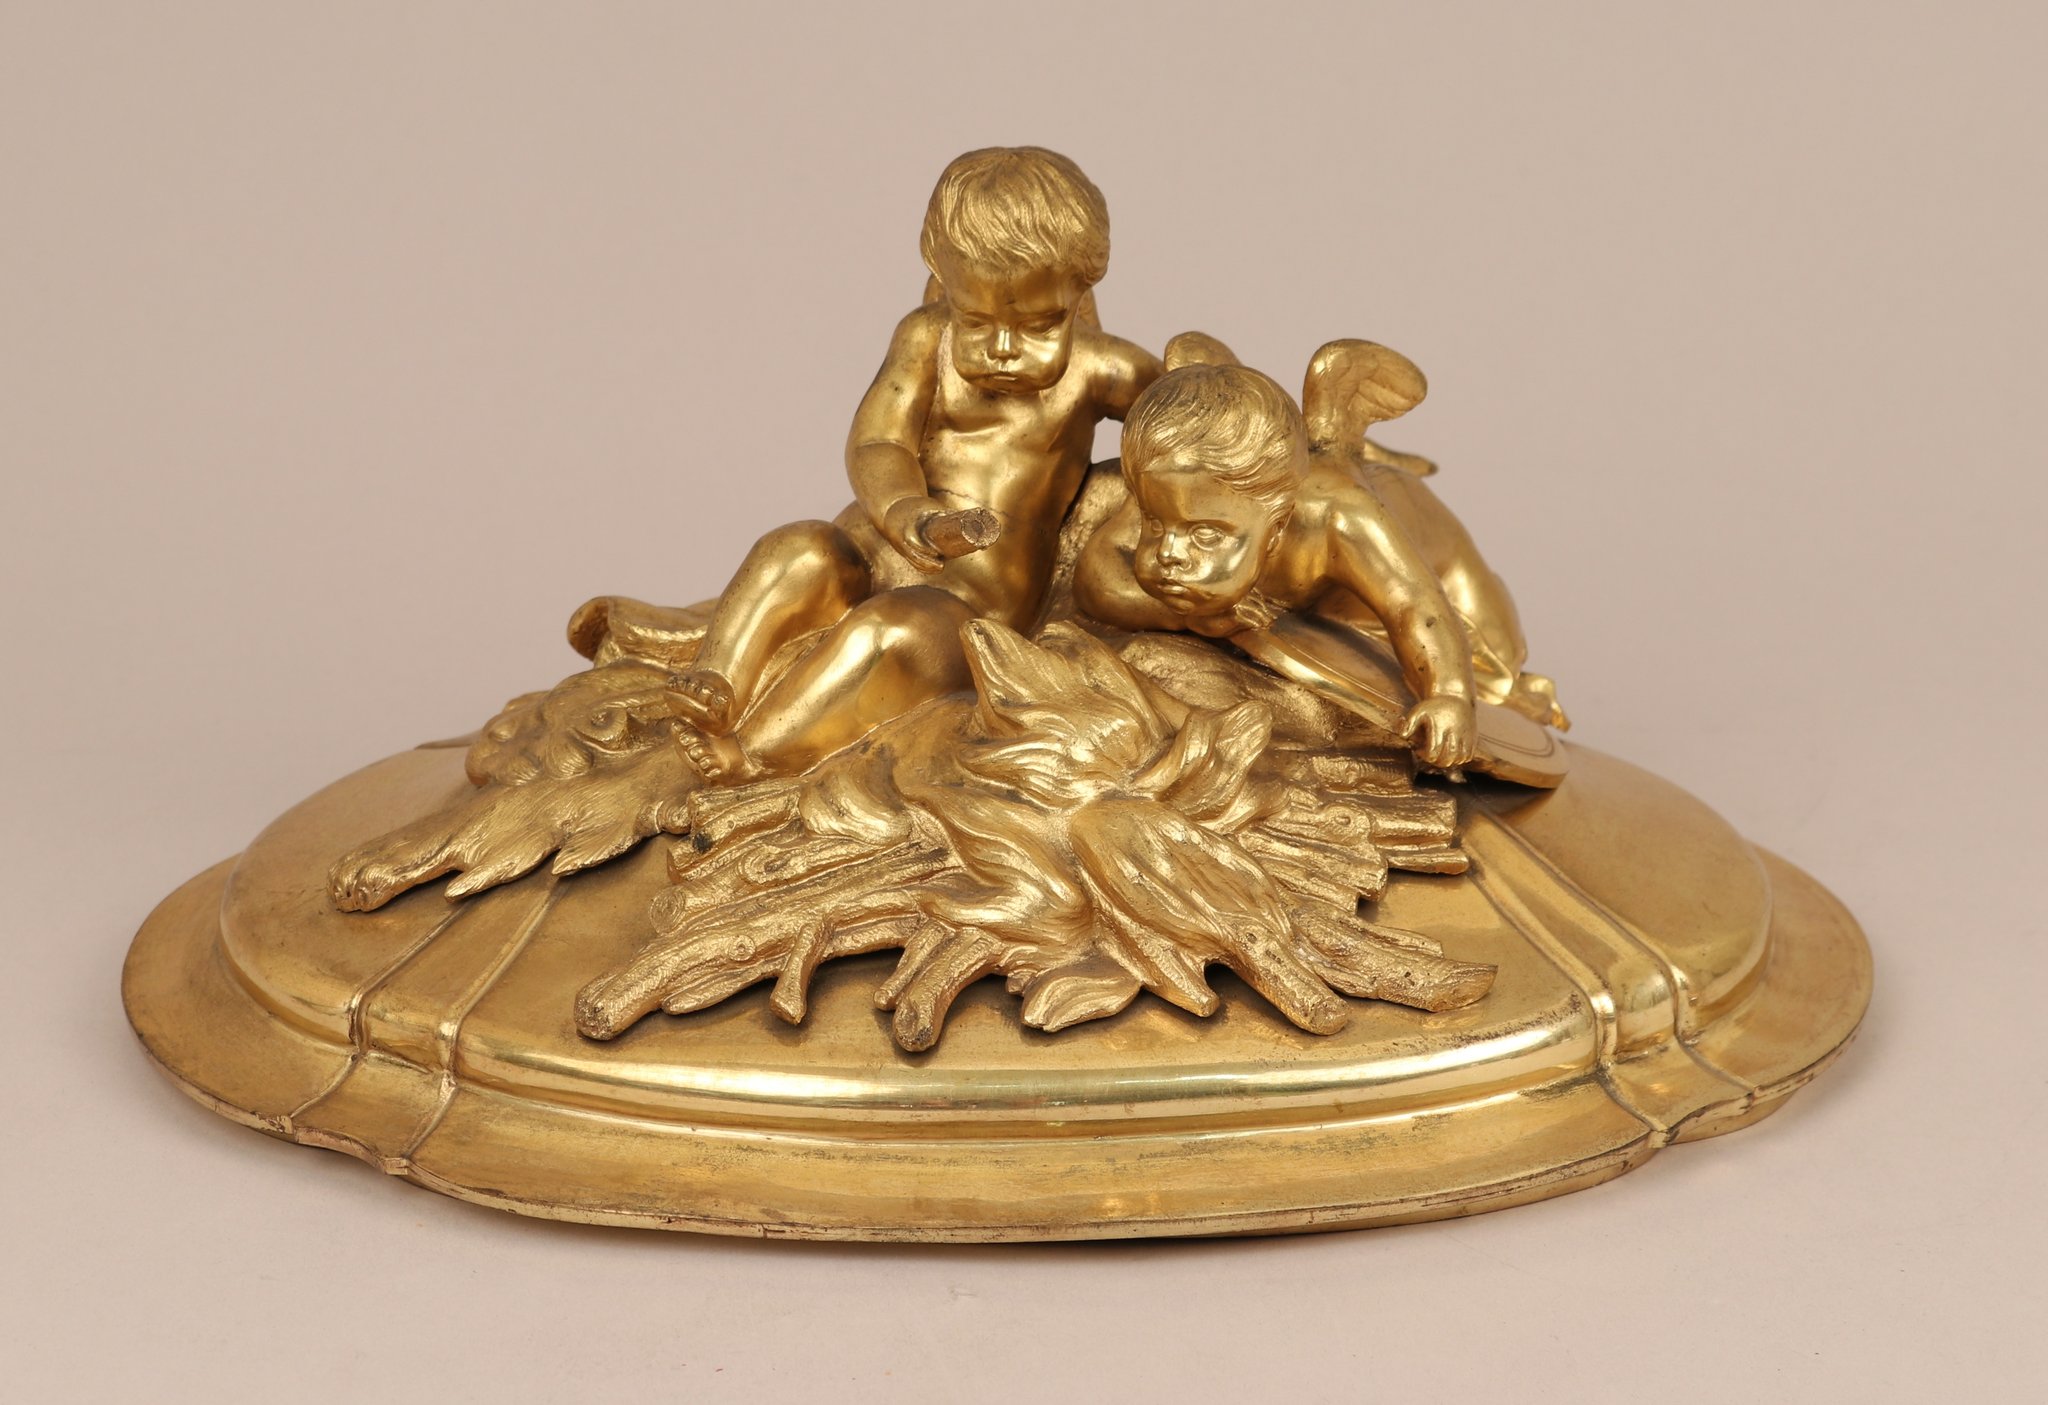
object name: tureen with cover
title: Tureen cover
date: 1801-1900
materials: metal, silver